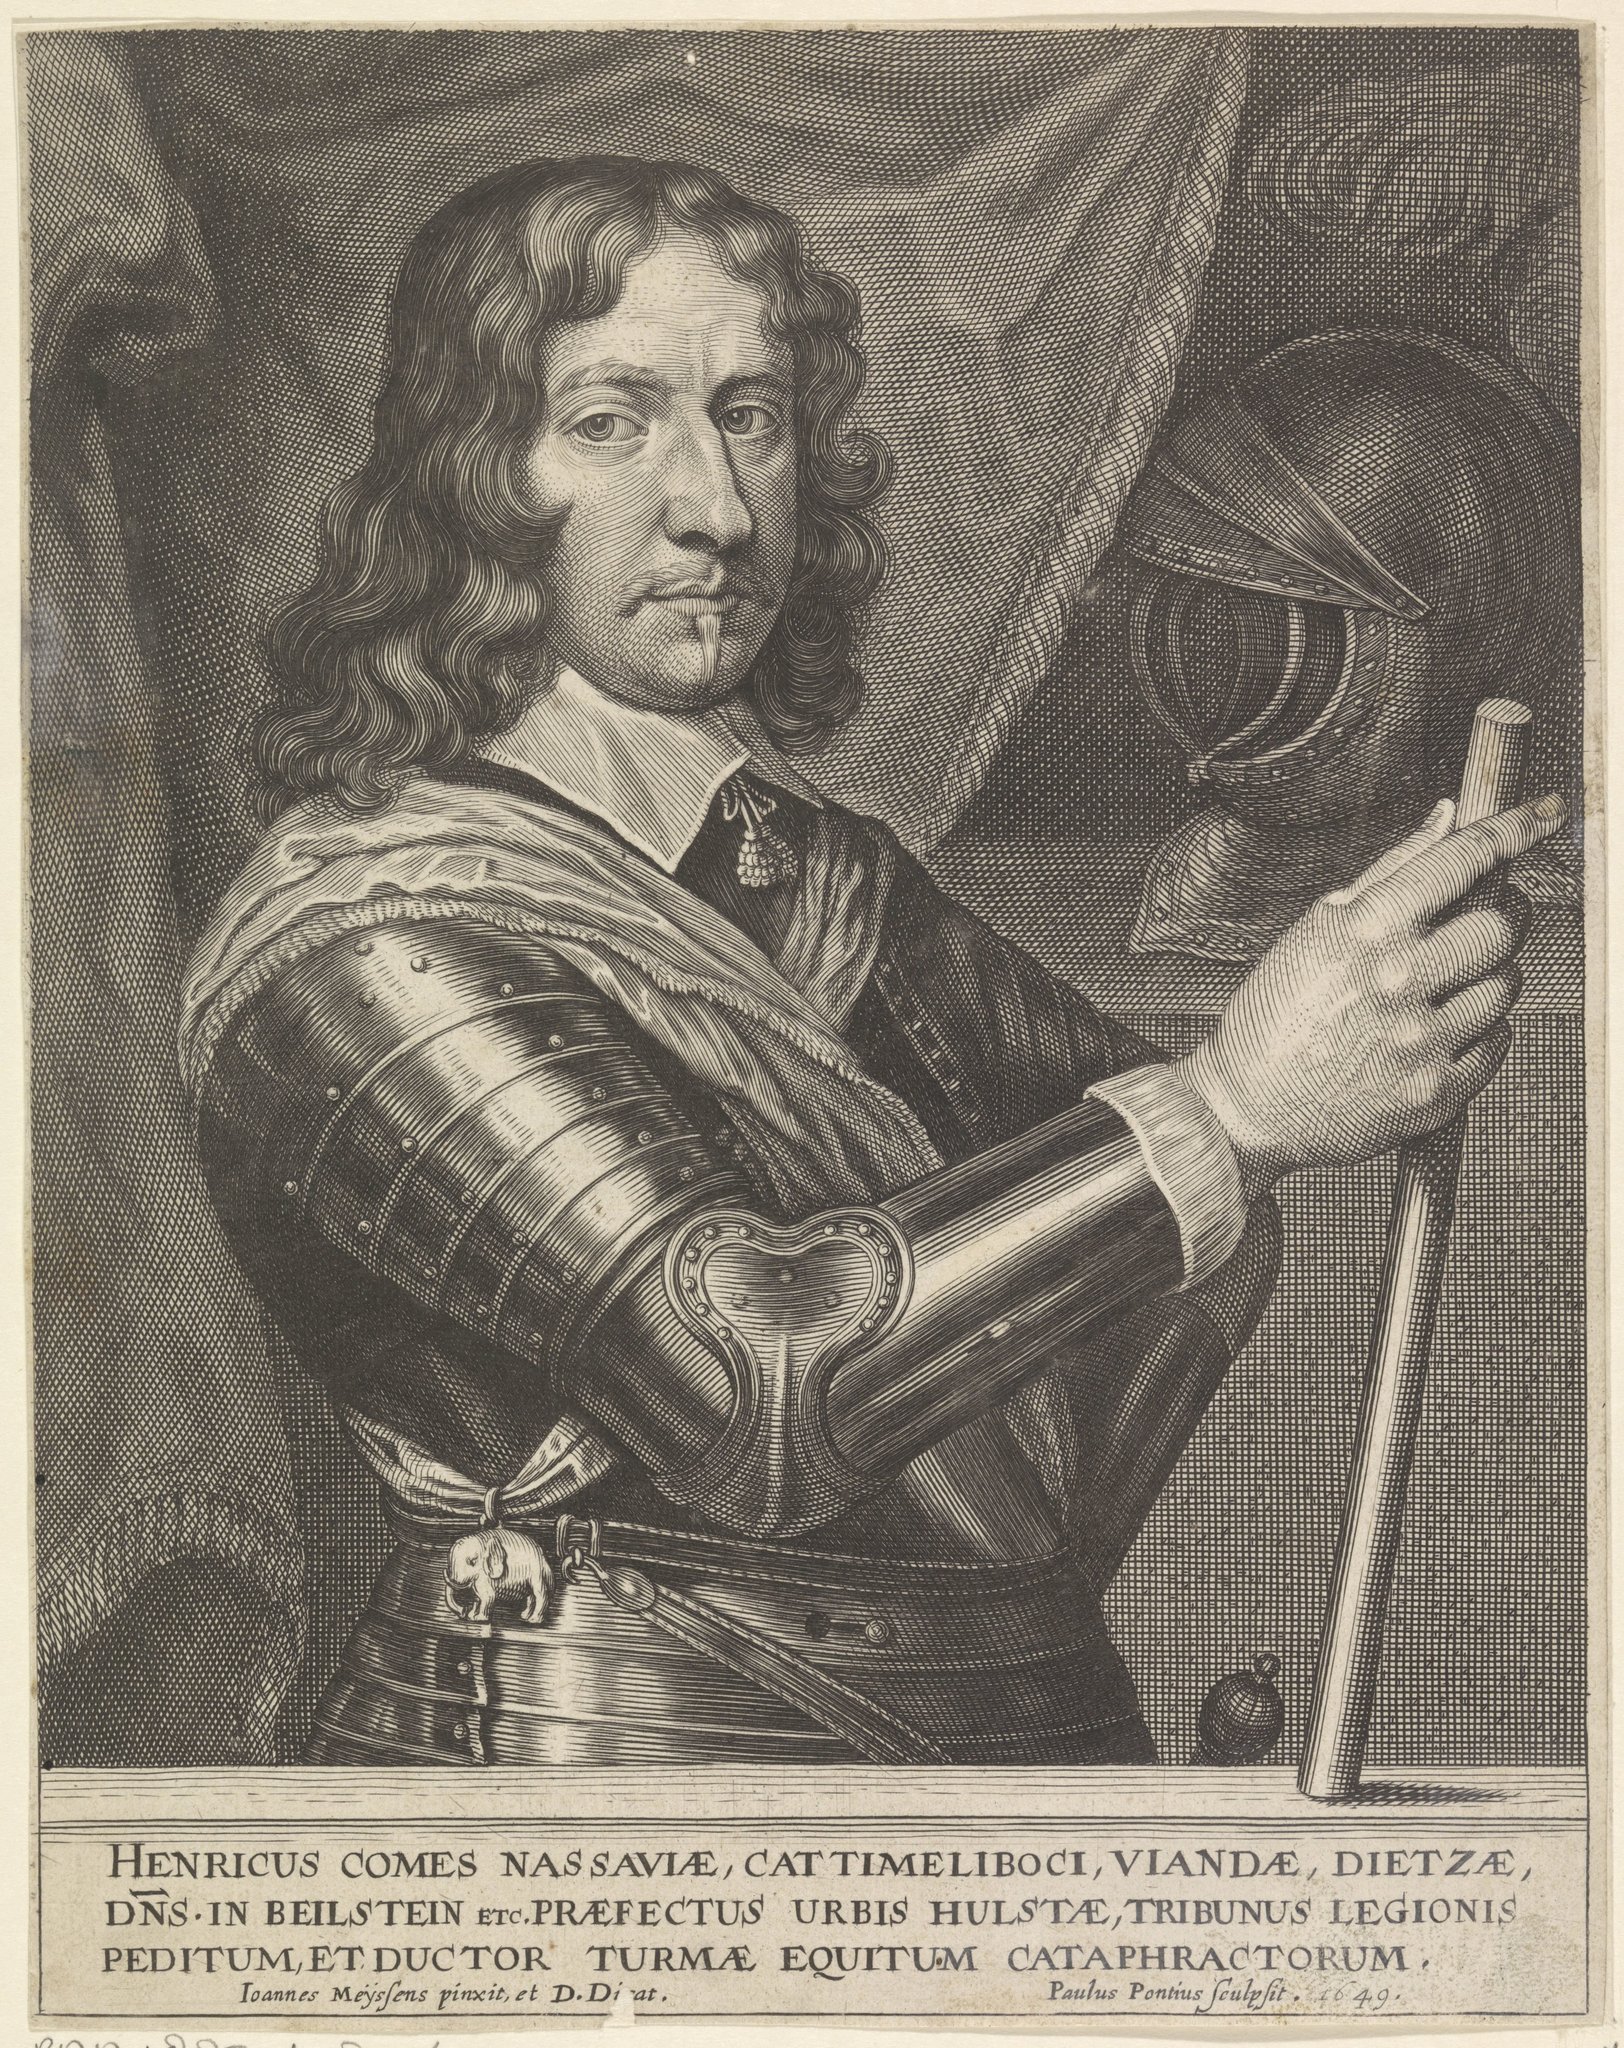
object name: print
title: Portret van Hendrik, graaf van Nassau-Siegen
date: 1649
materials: paper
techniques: engraving, etching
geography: antwerp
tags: graaf hendrik van nassau-siegen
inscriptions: collector's mark: Lugt 2228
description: De hier vermelde titel verwijst naar de hoogst verkregen titel van de geportretteerde, niet per se naar de titel die de geportretteerde op deze voorstelling draagt.